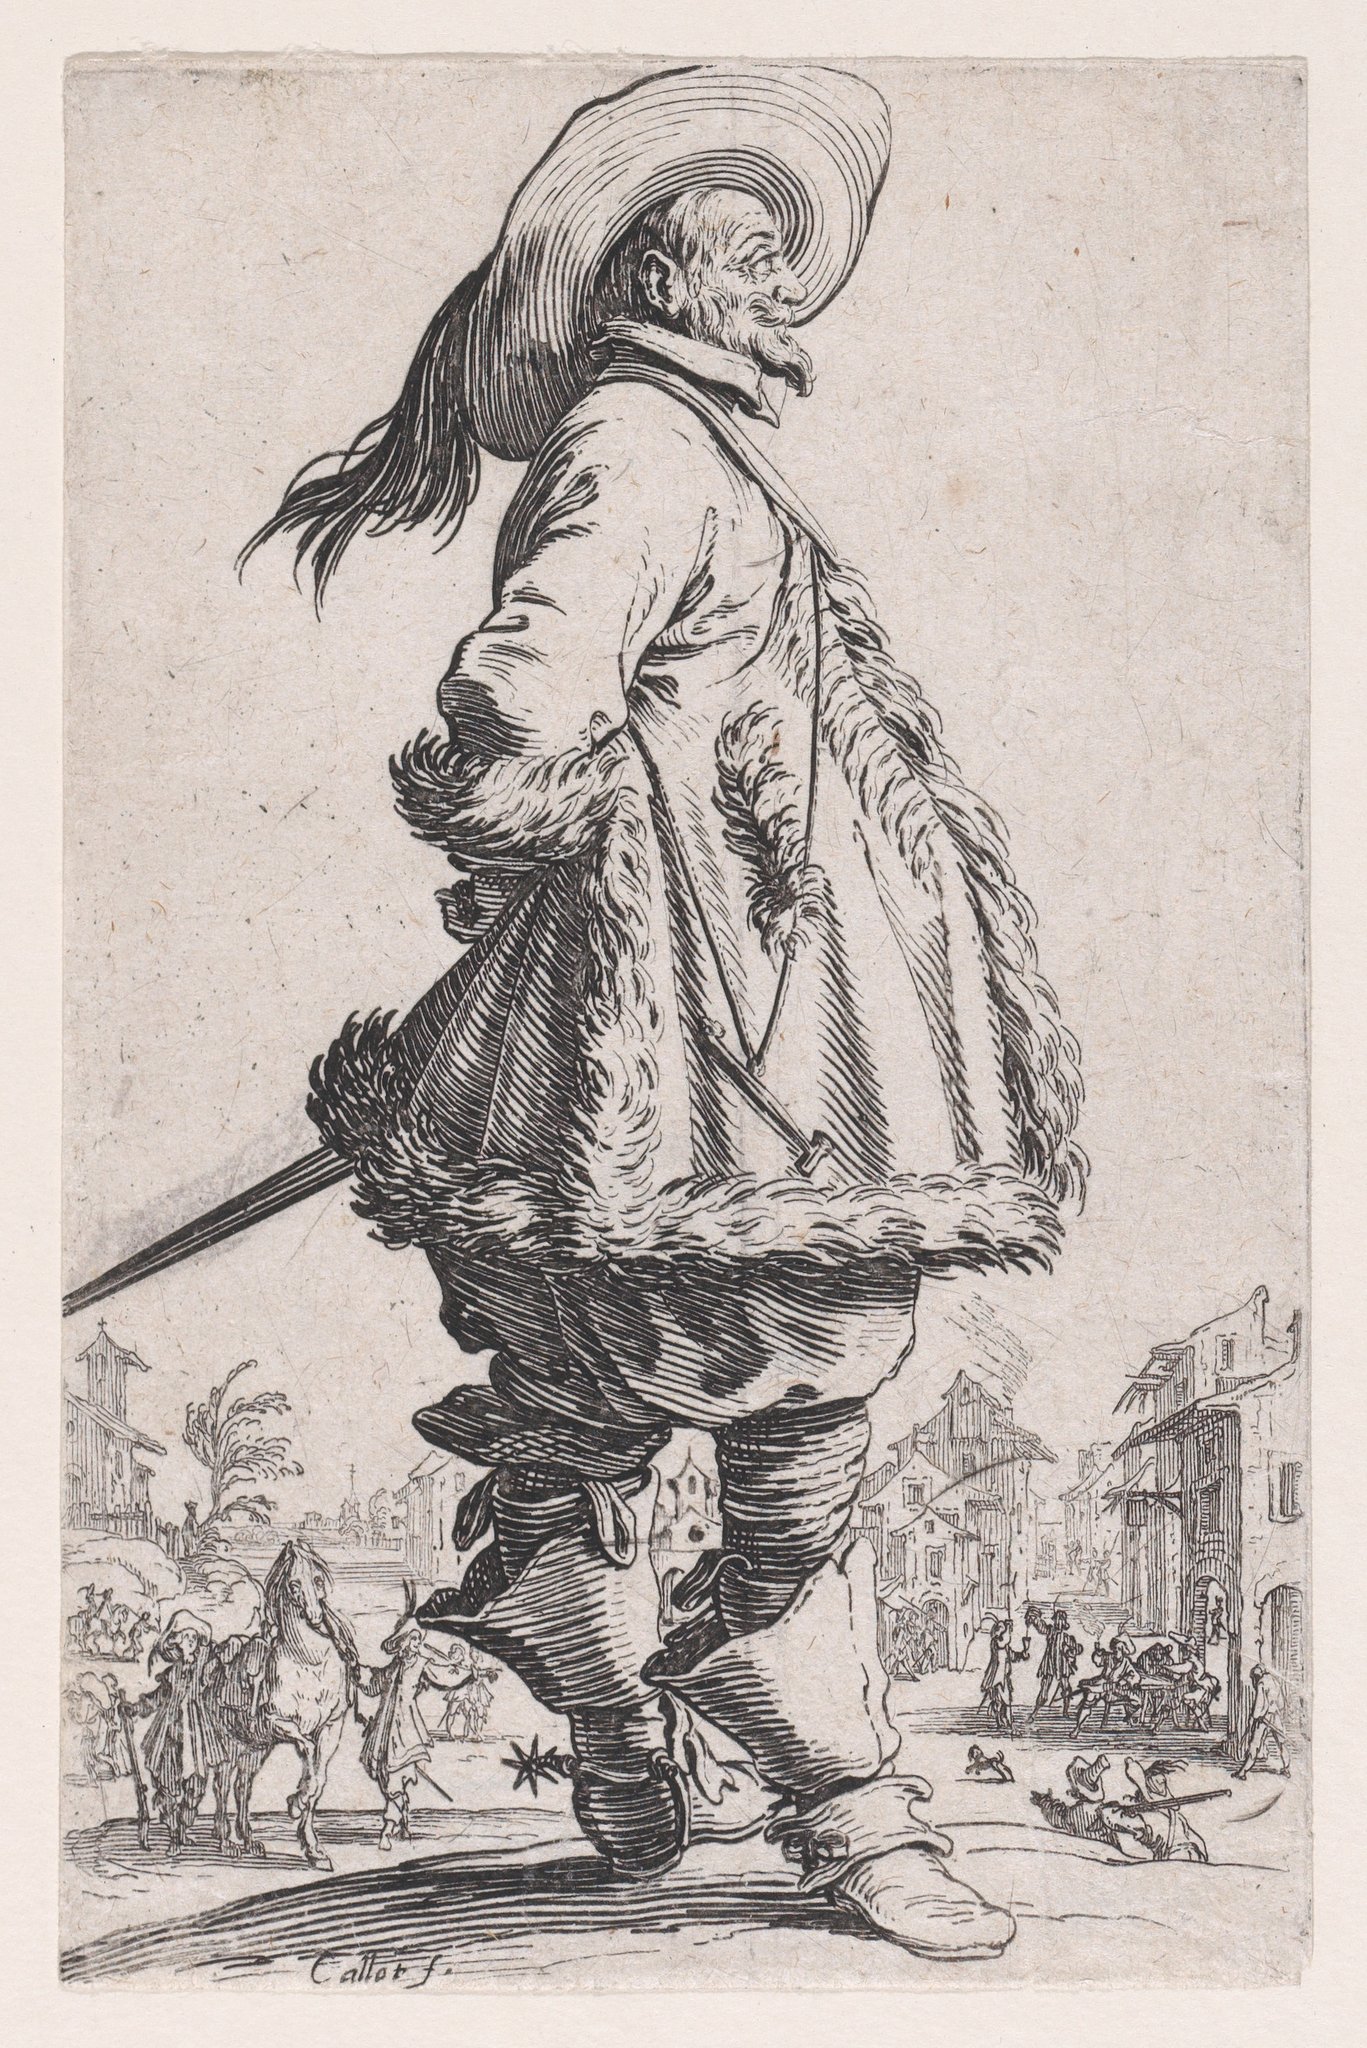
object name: print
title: Le Gentilhomme au Manteau Bordé de Fourrures Tenant ses Mains Derrière le Dos (The Gentleman with the Fur-Lined Mantle Holding his Hands Behind his Back), from "La Noblesse" (The Nobility)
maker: jacques callot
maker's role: artist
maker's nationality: french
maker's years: 1592-1635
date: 1623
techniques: etching